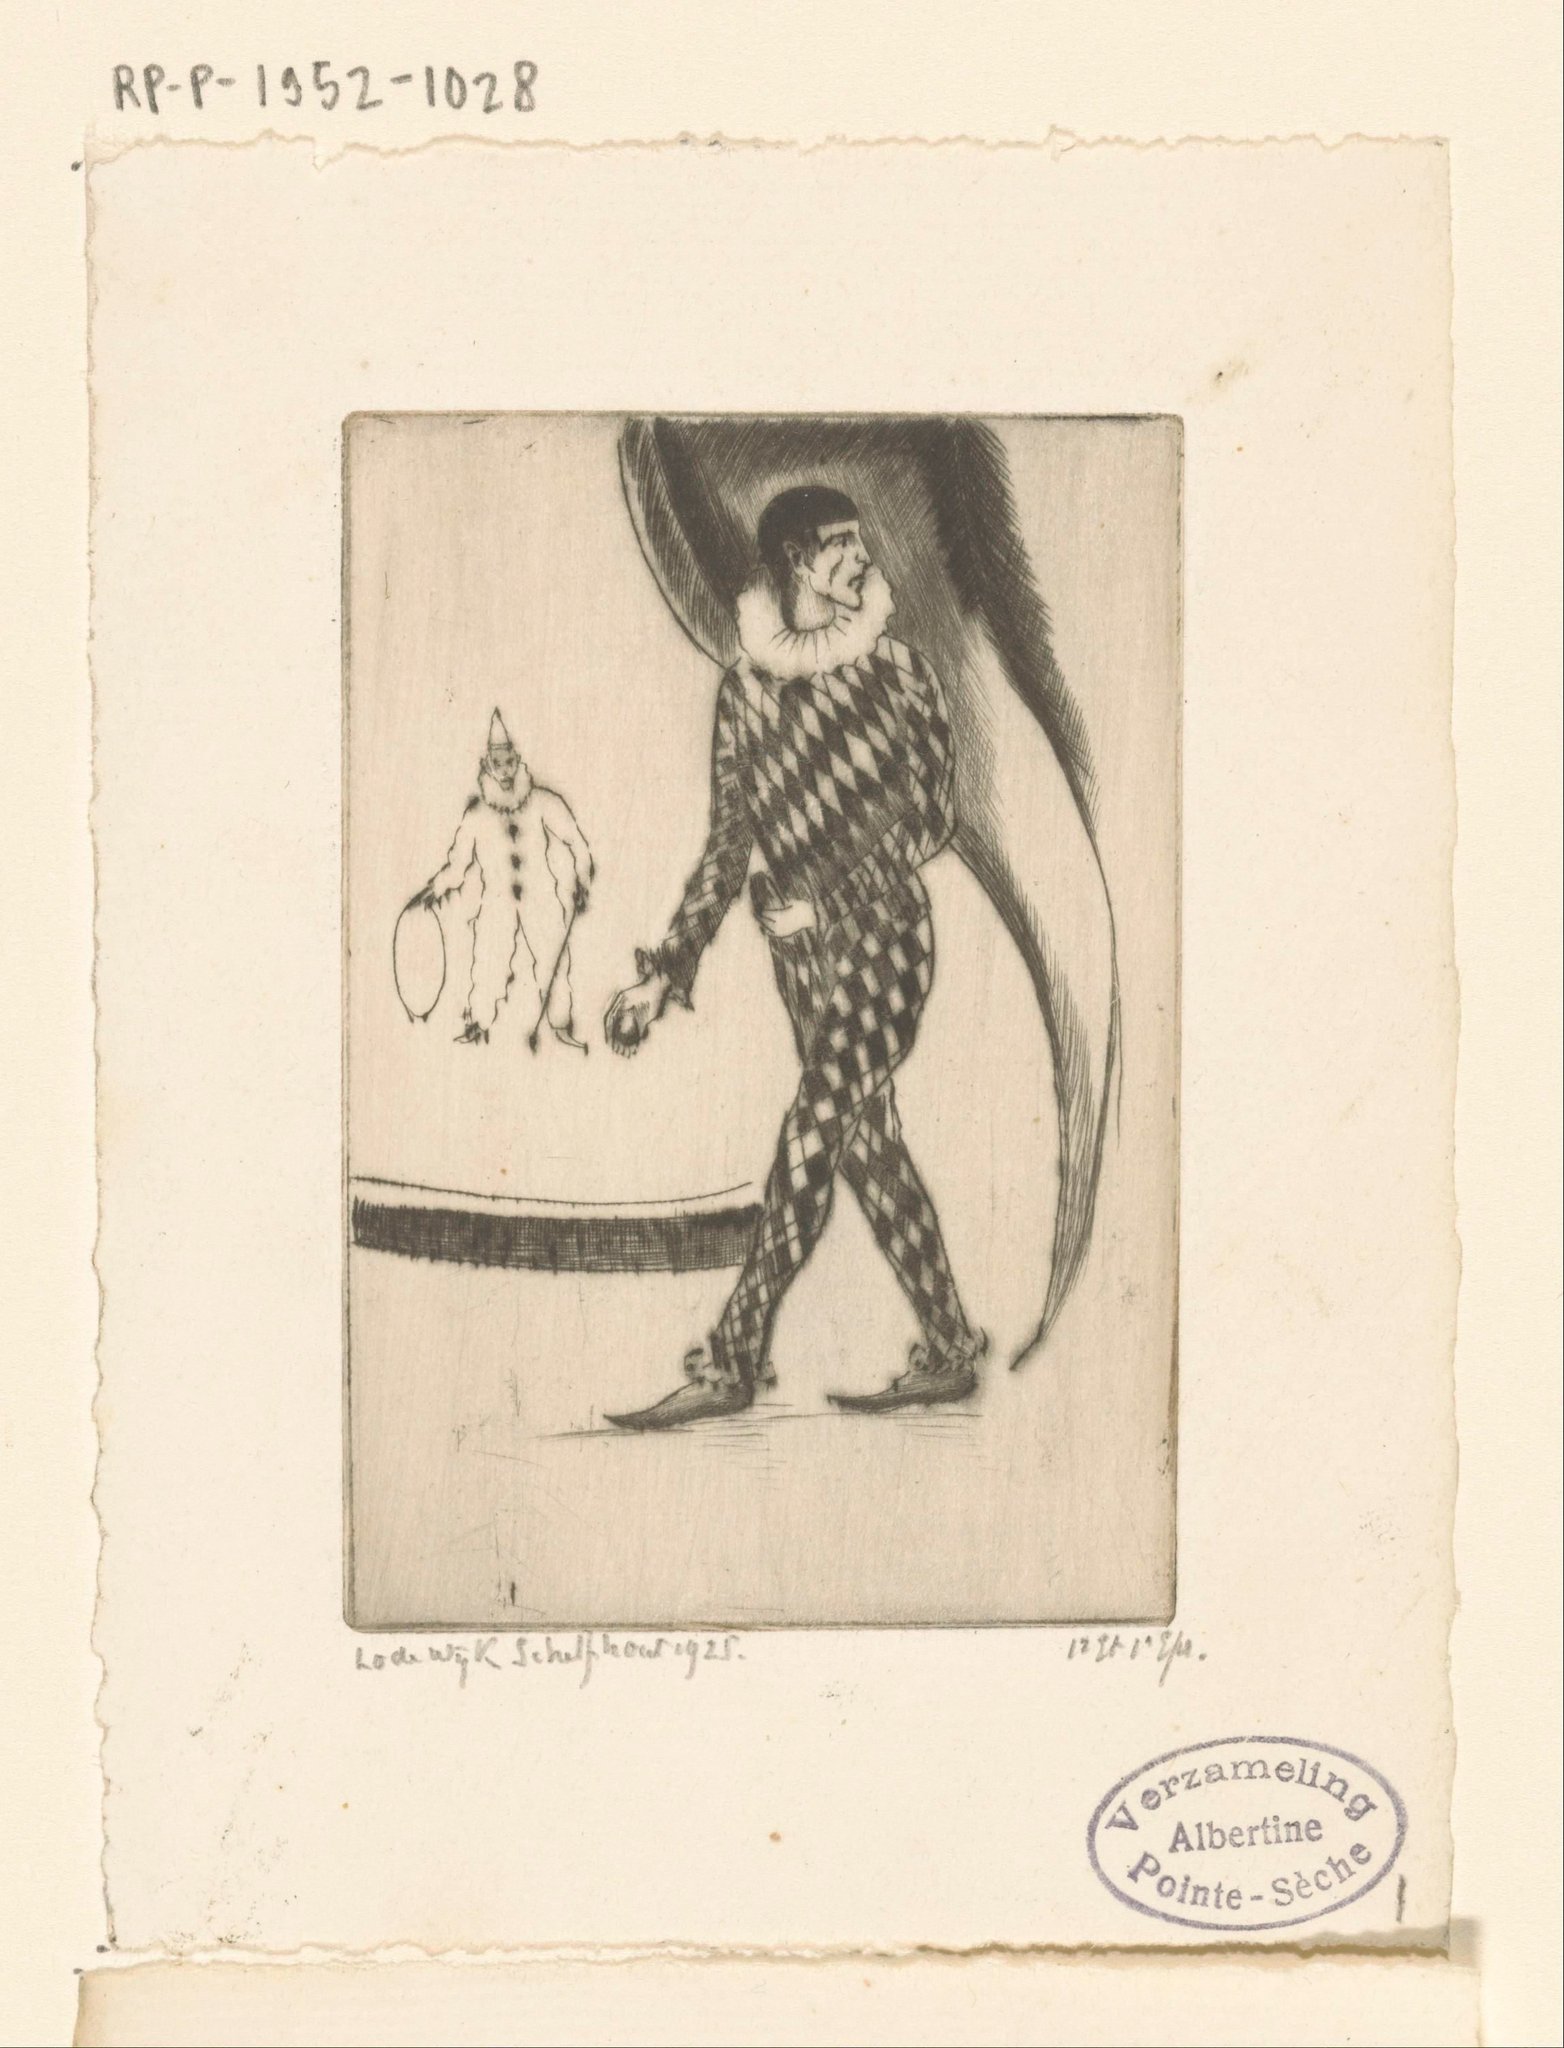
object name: print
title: Harlekijn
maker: lodewijk schelfhout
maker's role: draughtsman, print maker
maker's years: 1881-1943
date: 1925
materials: paper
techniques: drypoint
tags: clown, types in 'commedia dell'arte': harlequin, circus ring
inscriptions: collector's mark: Lugt 5i, collector's mark: Lugt 2760, collector's mark: Lugt 2228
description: Een harlekijn bij een circuspiste met daarin een clown met een hoepel.